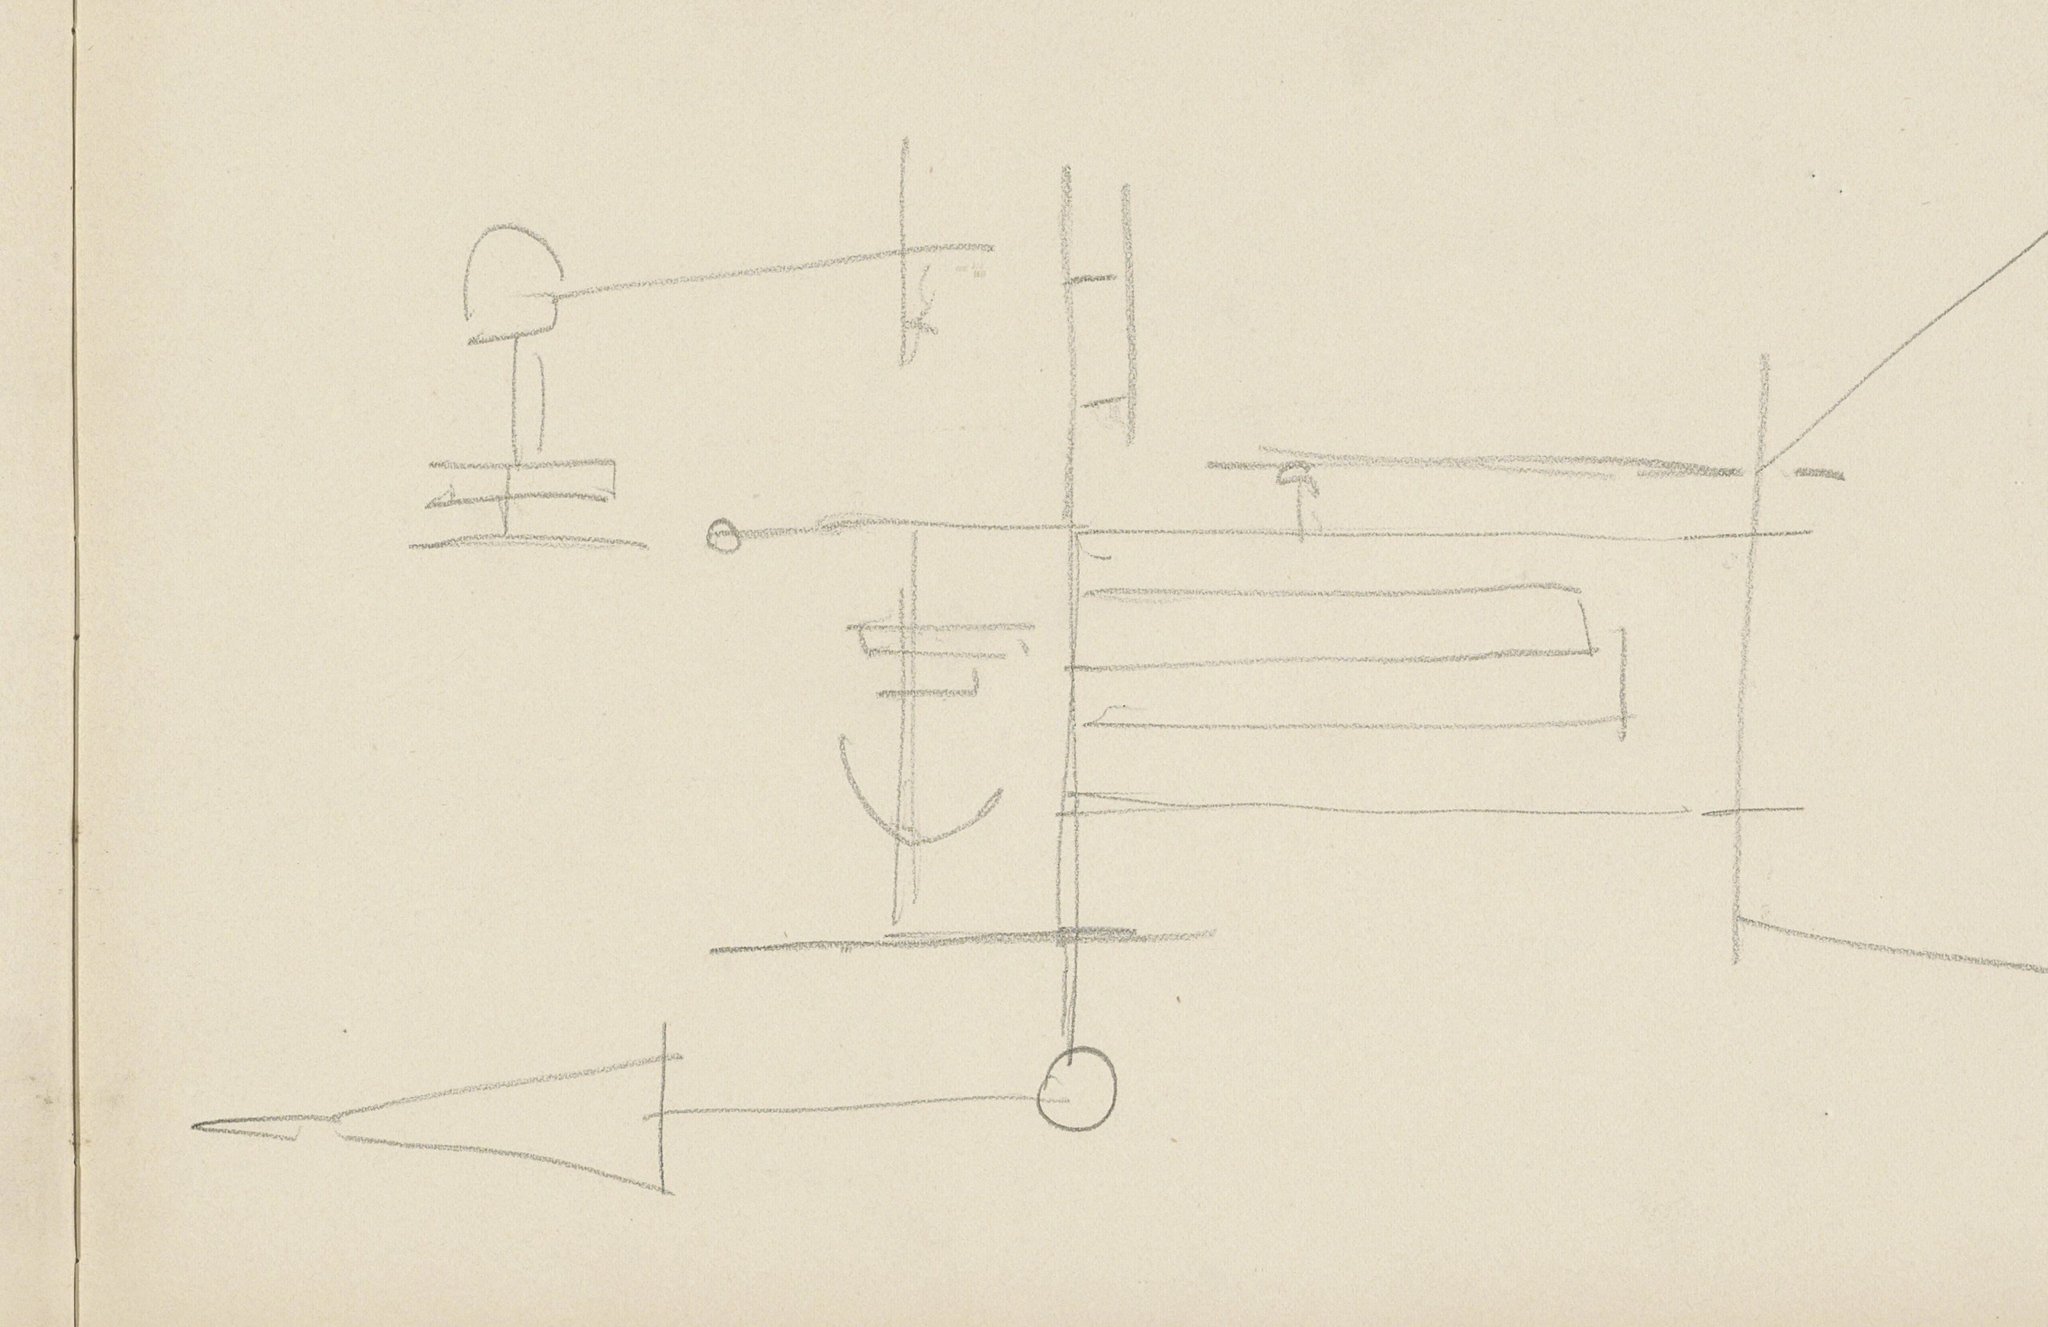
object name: sketchbook leaf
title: Studie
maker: carel adolph lion cachet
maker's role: draughtsman, print maker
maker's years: 1864-1945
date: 1908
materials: paper, pencil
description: Blad 11 recto uit een schetsboek met 25 bladen.